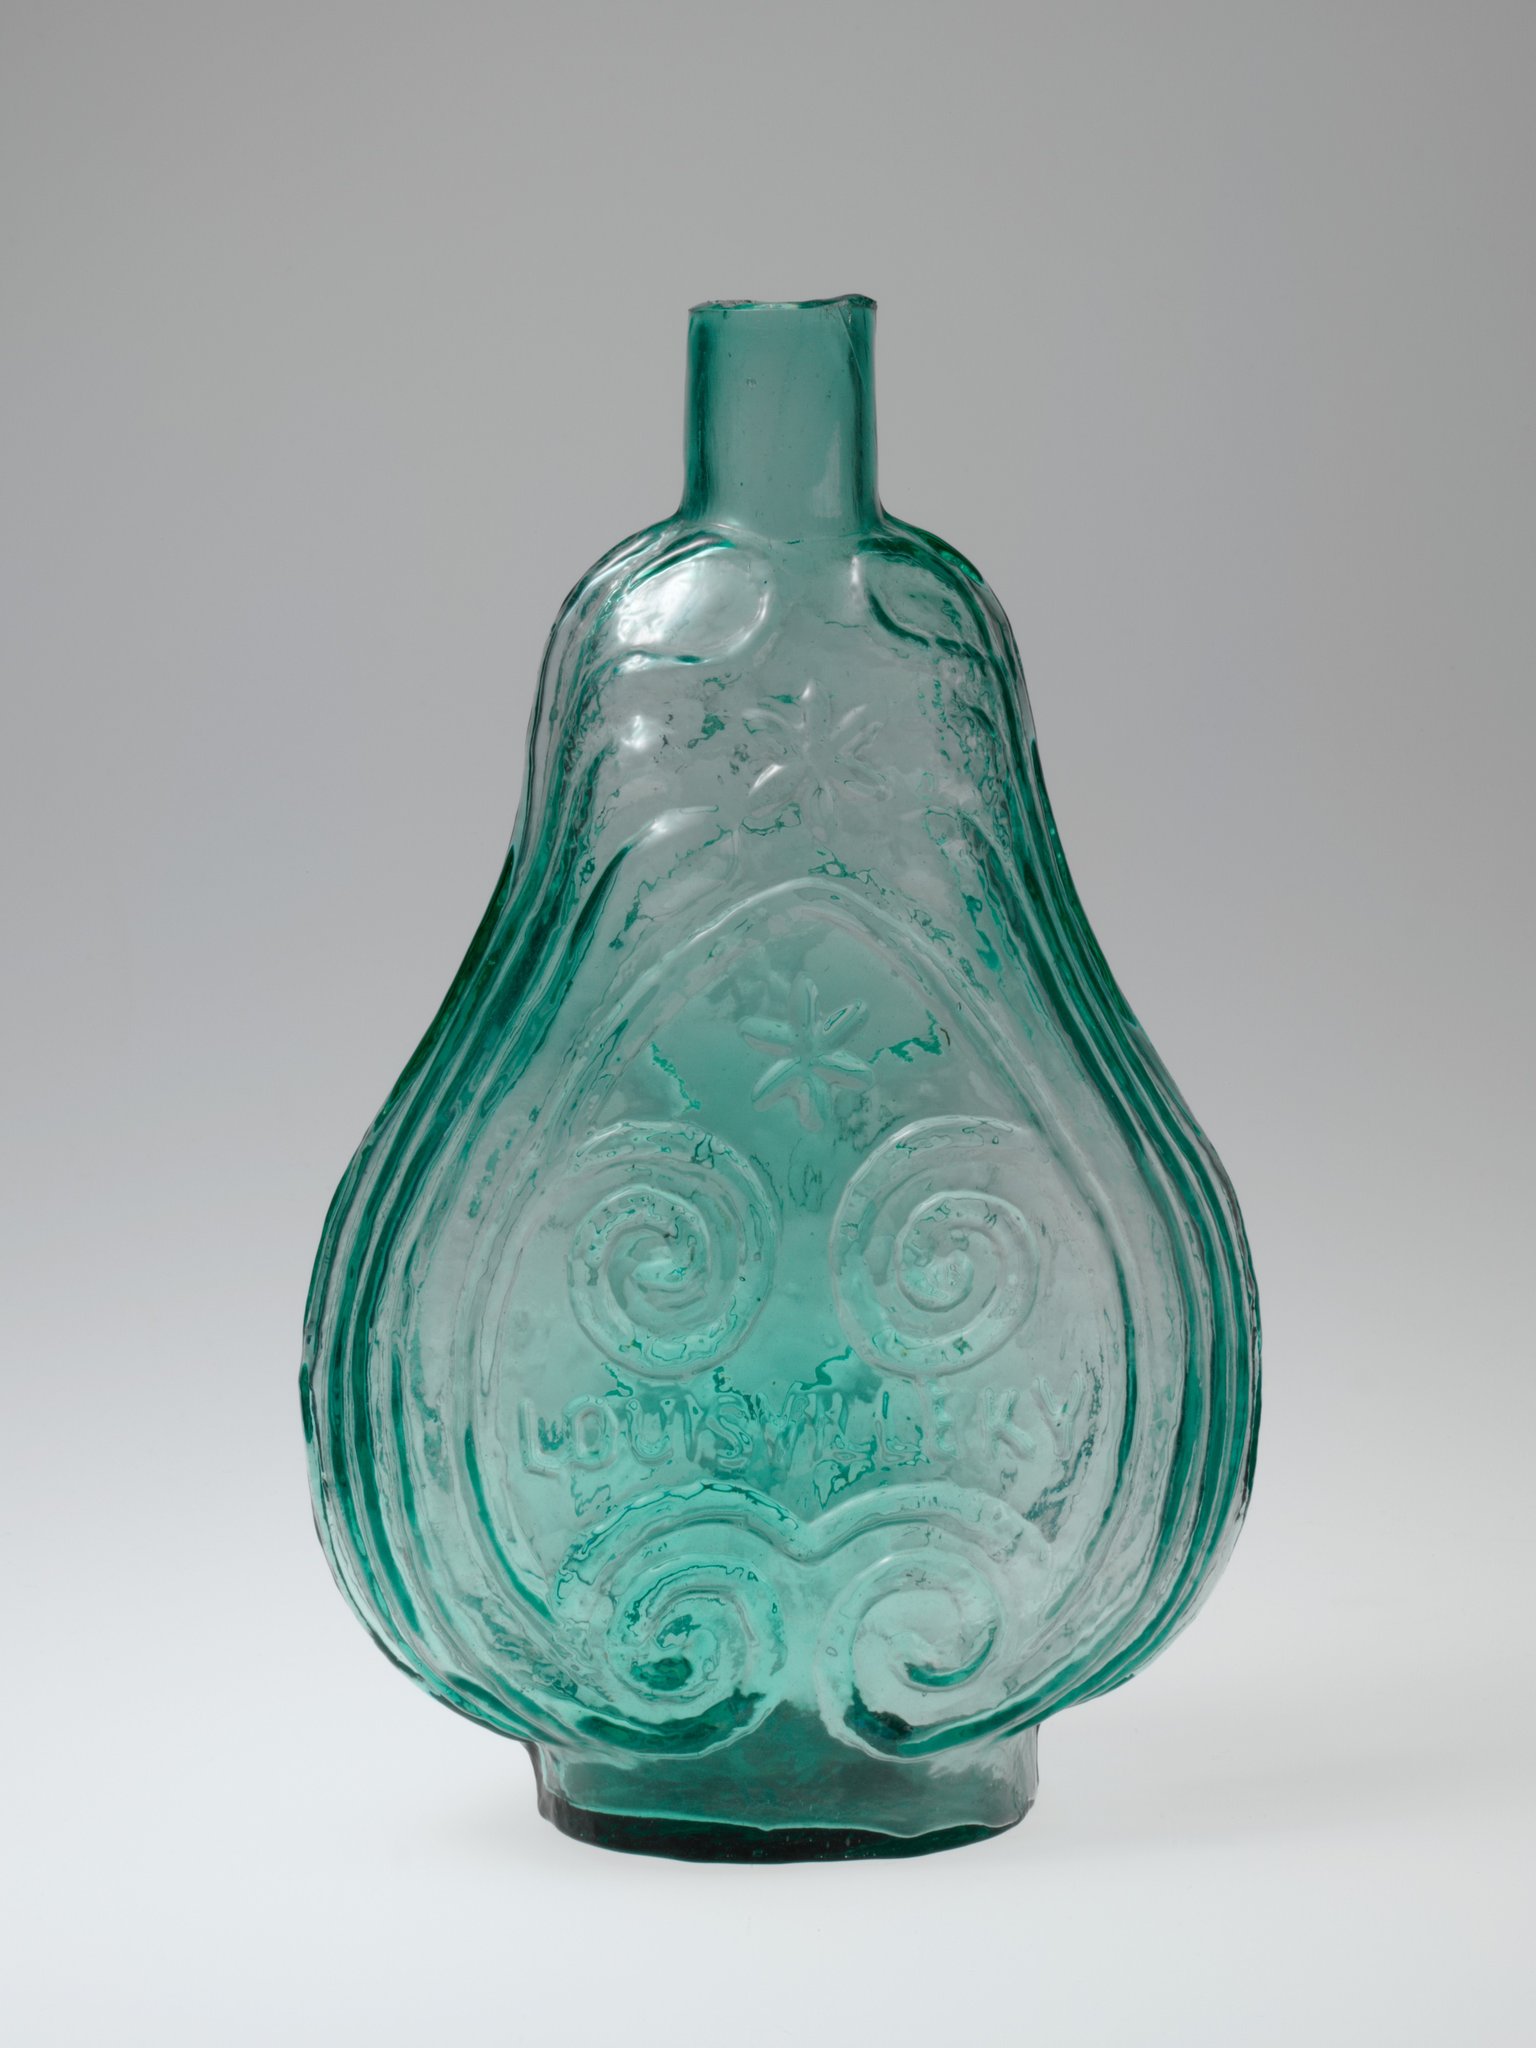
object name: flask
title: Figured flask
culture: american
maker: louisville glass works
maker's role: manufacturer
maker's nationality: american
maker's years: 1855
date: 1855-1873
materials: glass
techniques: glassblowing, molding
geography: united states